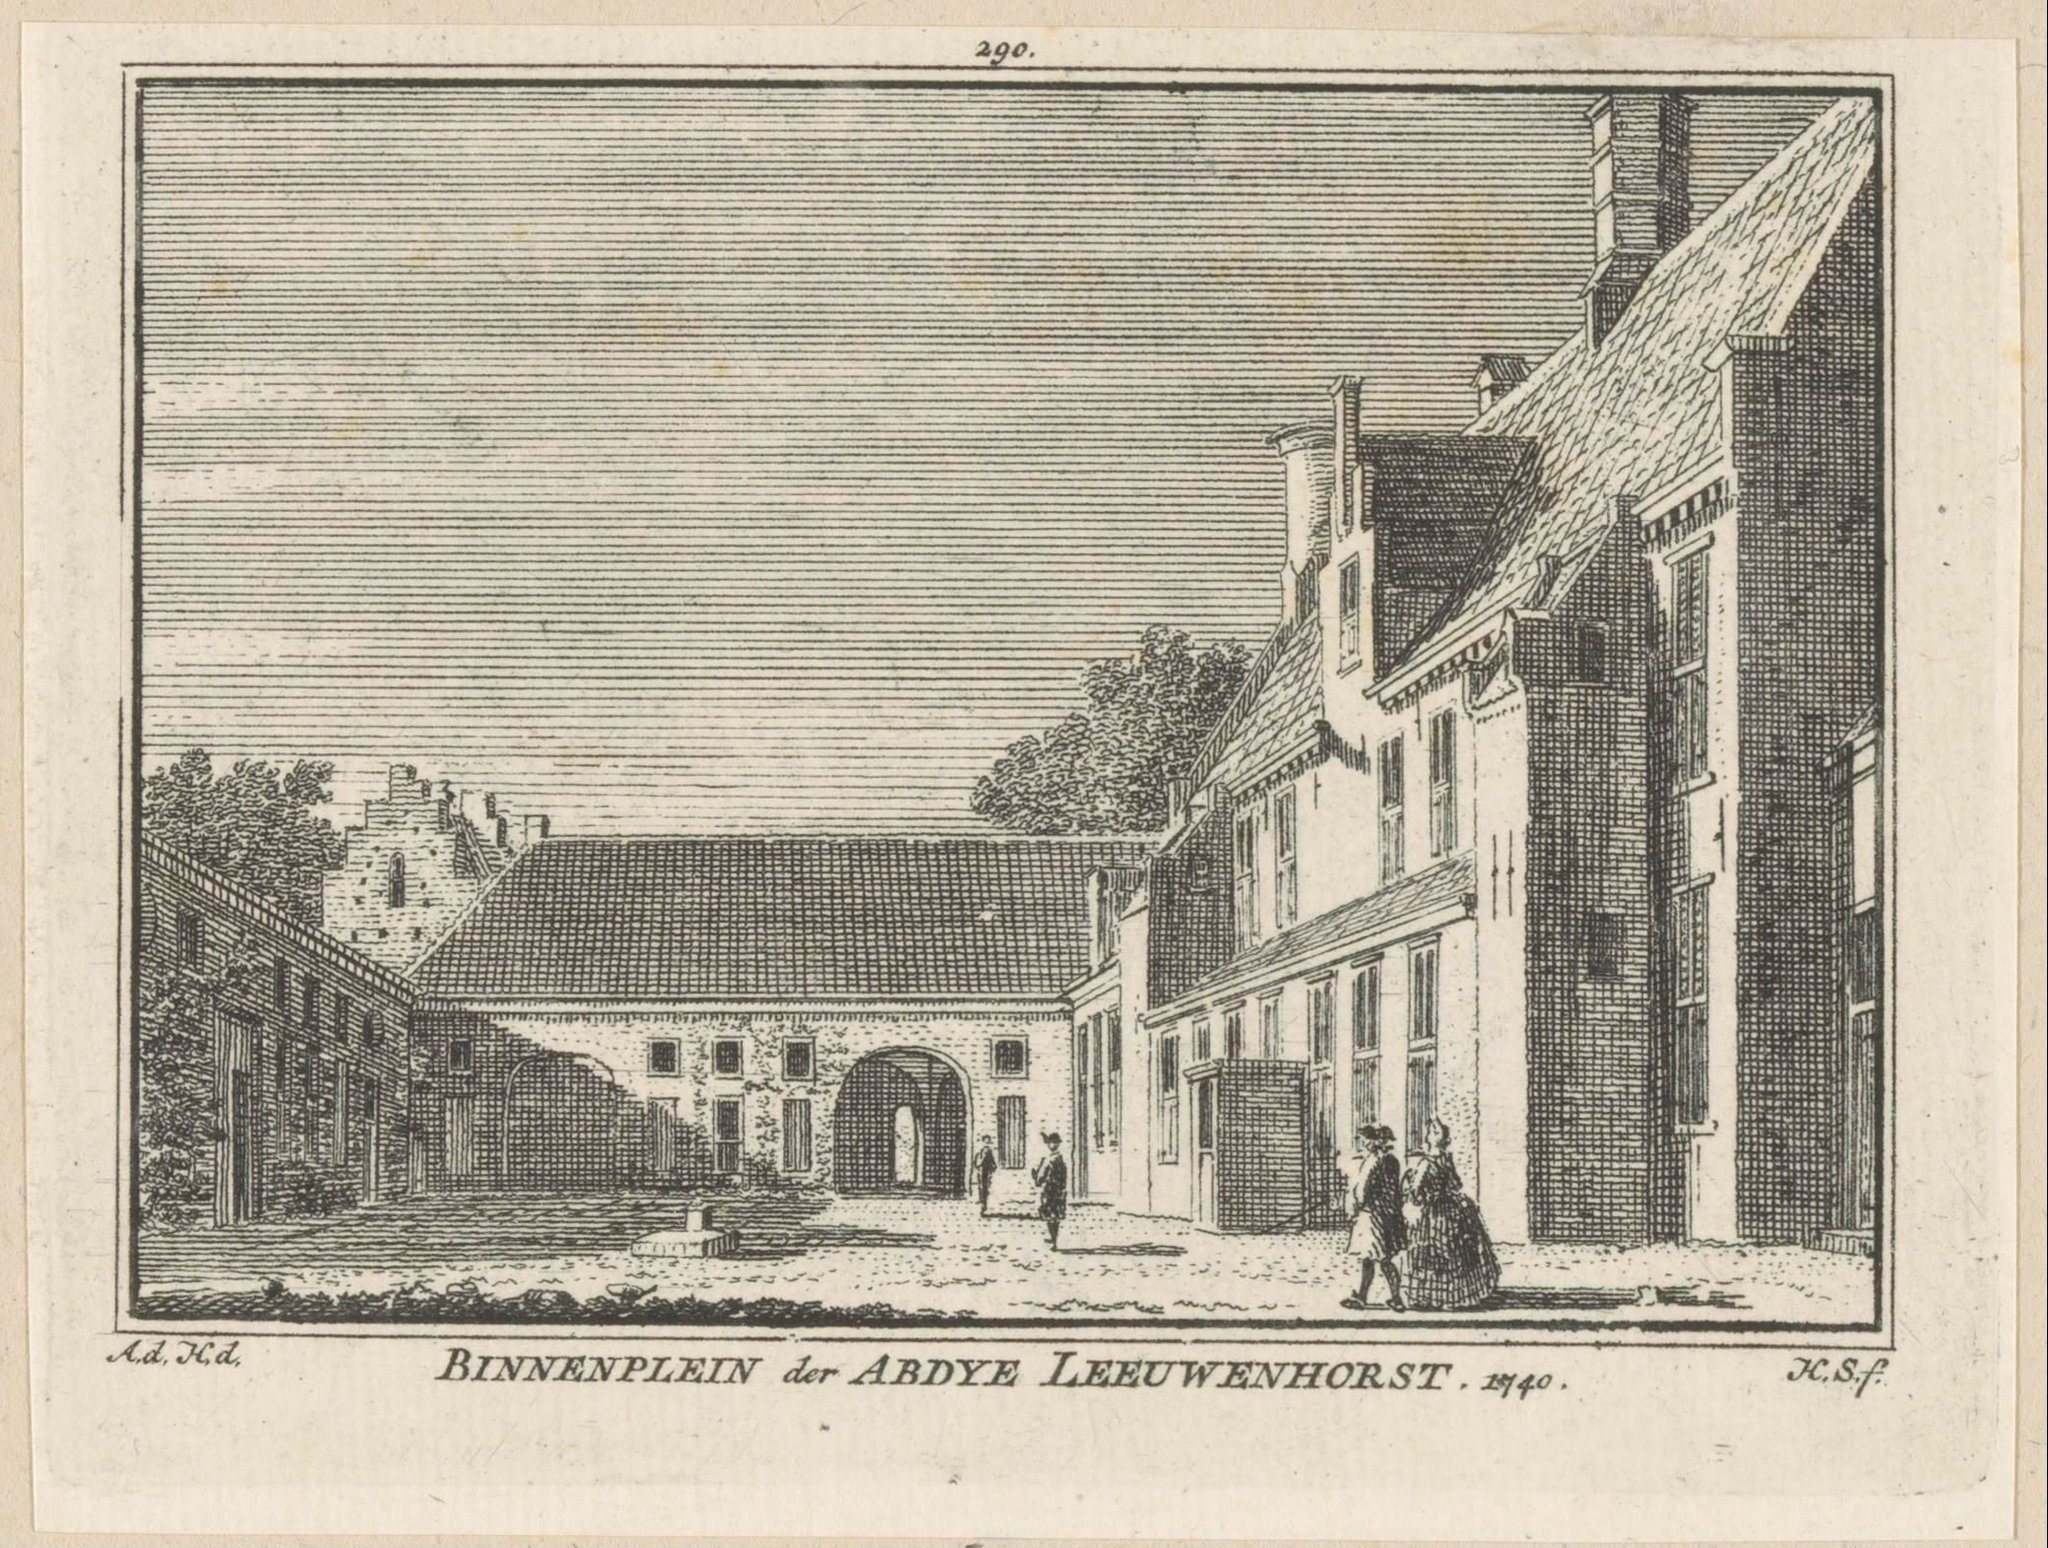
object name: book illustration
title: Gezicht op de binnenplaats van abdij Leeuwenhorst, 1740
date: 1750-1792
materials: paper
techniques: engraving, etching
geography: haarlem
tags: abbey, monastery, convent ~ roman catholic church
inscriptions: collector's mark: Lugt 2228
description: Prent ook gebruikt in: Het verheerlykt Nederland of kabinet van hedendaagsche gezigten van steden, dorpen (…). 9 delen. Amsterdam: Isaak Tirion en weduwe Isaak Tirion, 1745-1774, dl. 3 (1750), ill. 290. Of in: Nederlandsche tafereelen; of eene keurige verzameling van negen honderd fraaije gezigten van steden, dorpen, sloten, oudheden (….). 9 delen. Amsterdam: Jan de Groot, 1792, dl. 3, ill. 290.